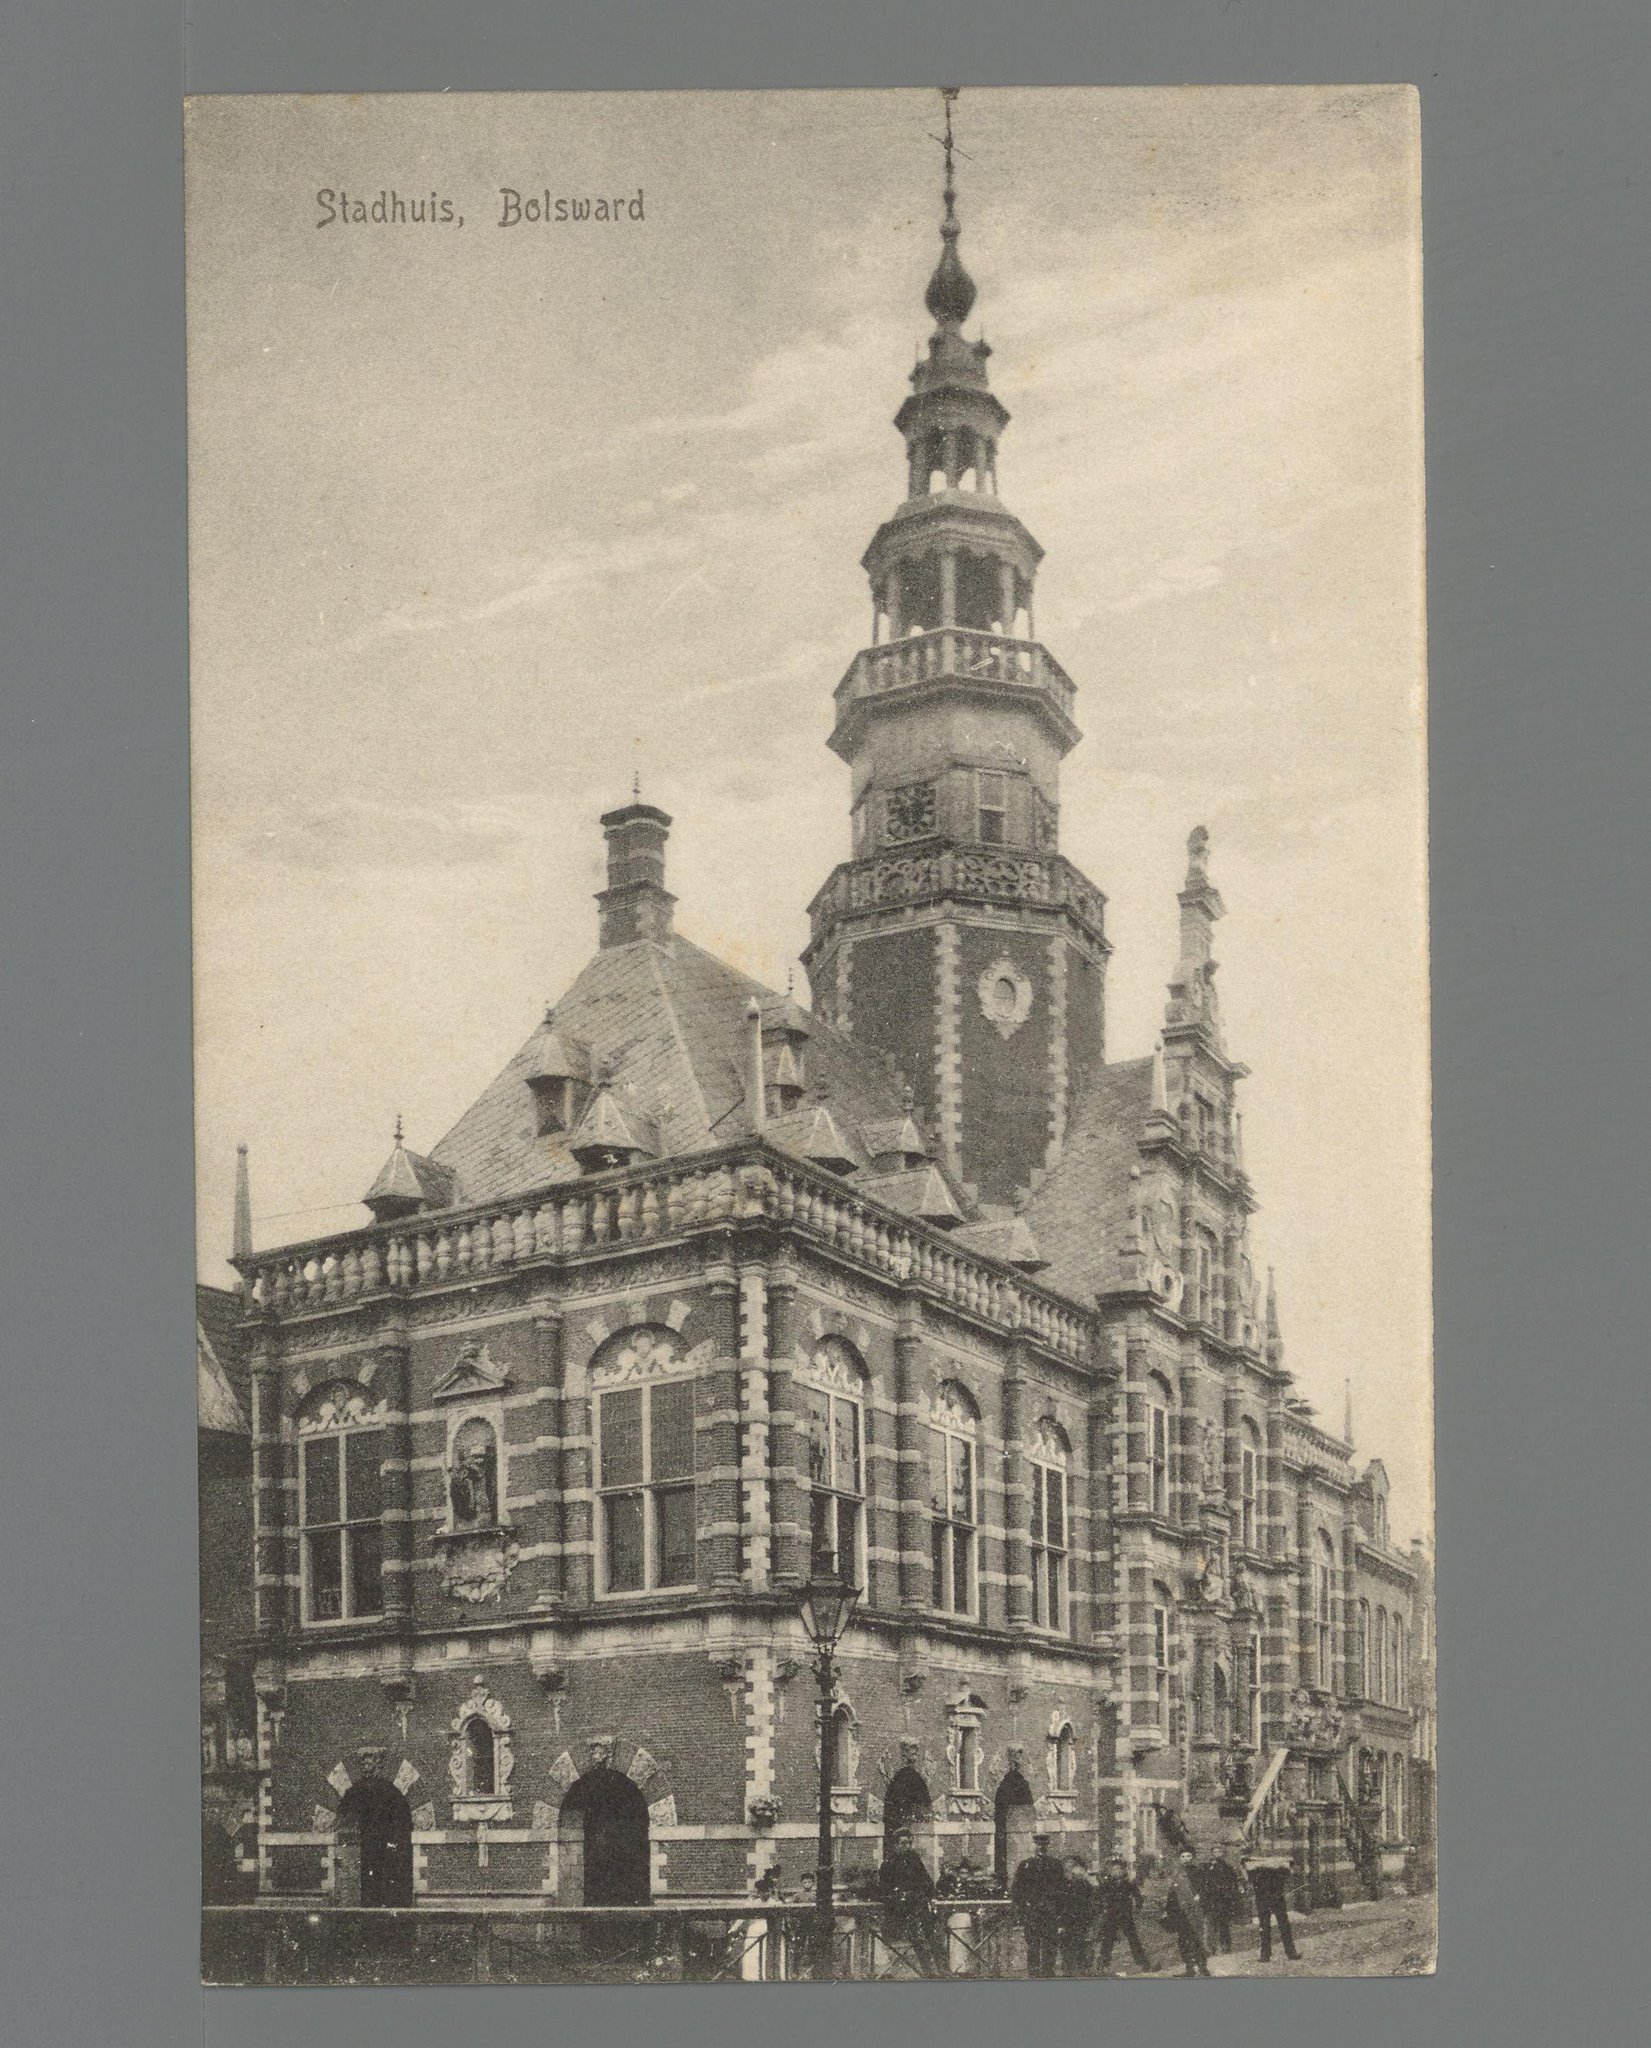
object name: photomechanical print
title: Stadhuis, Bolsward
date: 1905-1930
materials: cardboard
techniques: photograph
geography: bolsward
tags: townhall